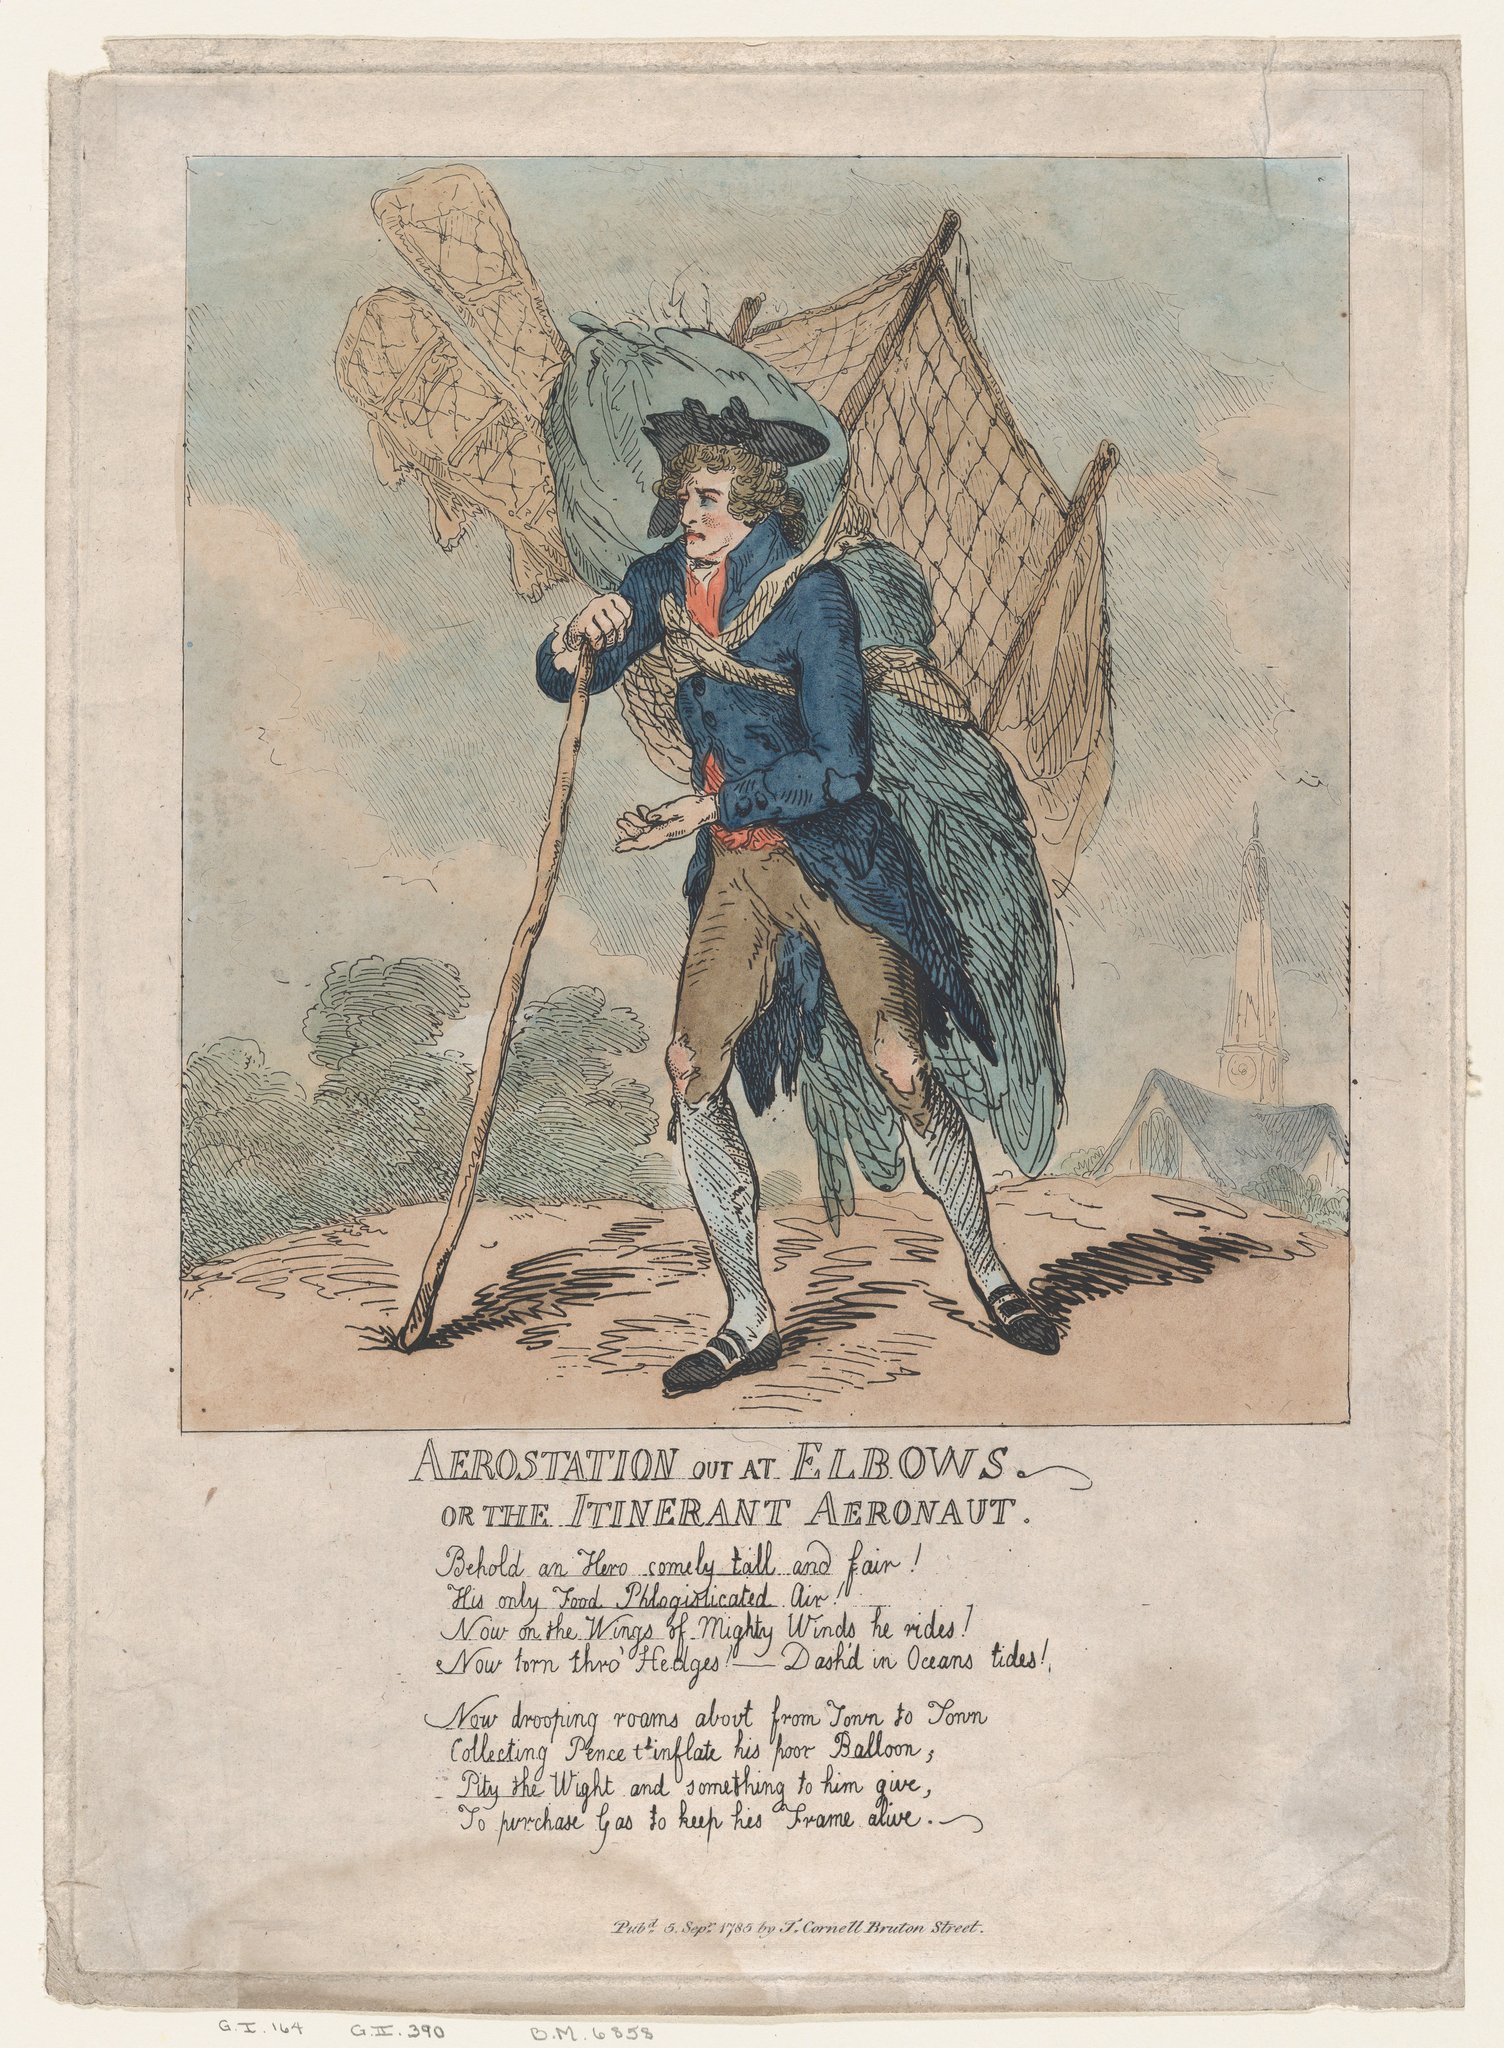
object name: print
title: Aerostation out at Elbows, or The Itinerant Aeronaut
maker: thomas rowlandson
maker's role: artist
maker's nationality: british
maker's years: 1757-1827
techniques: etching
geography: england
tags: satire,men,hot air balloons